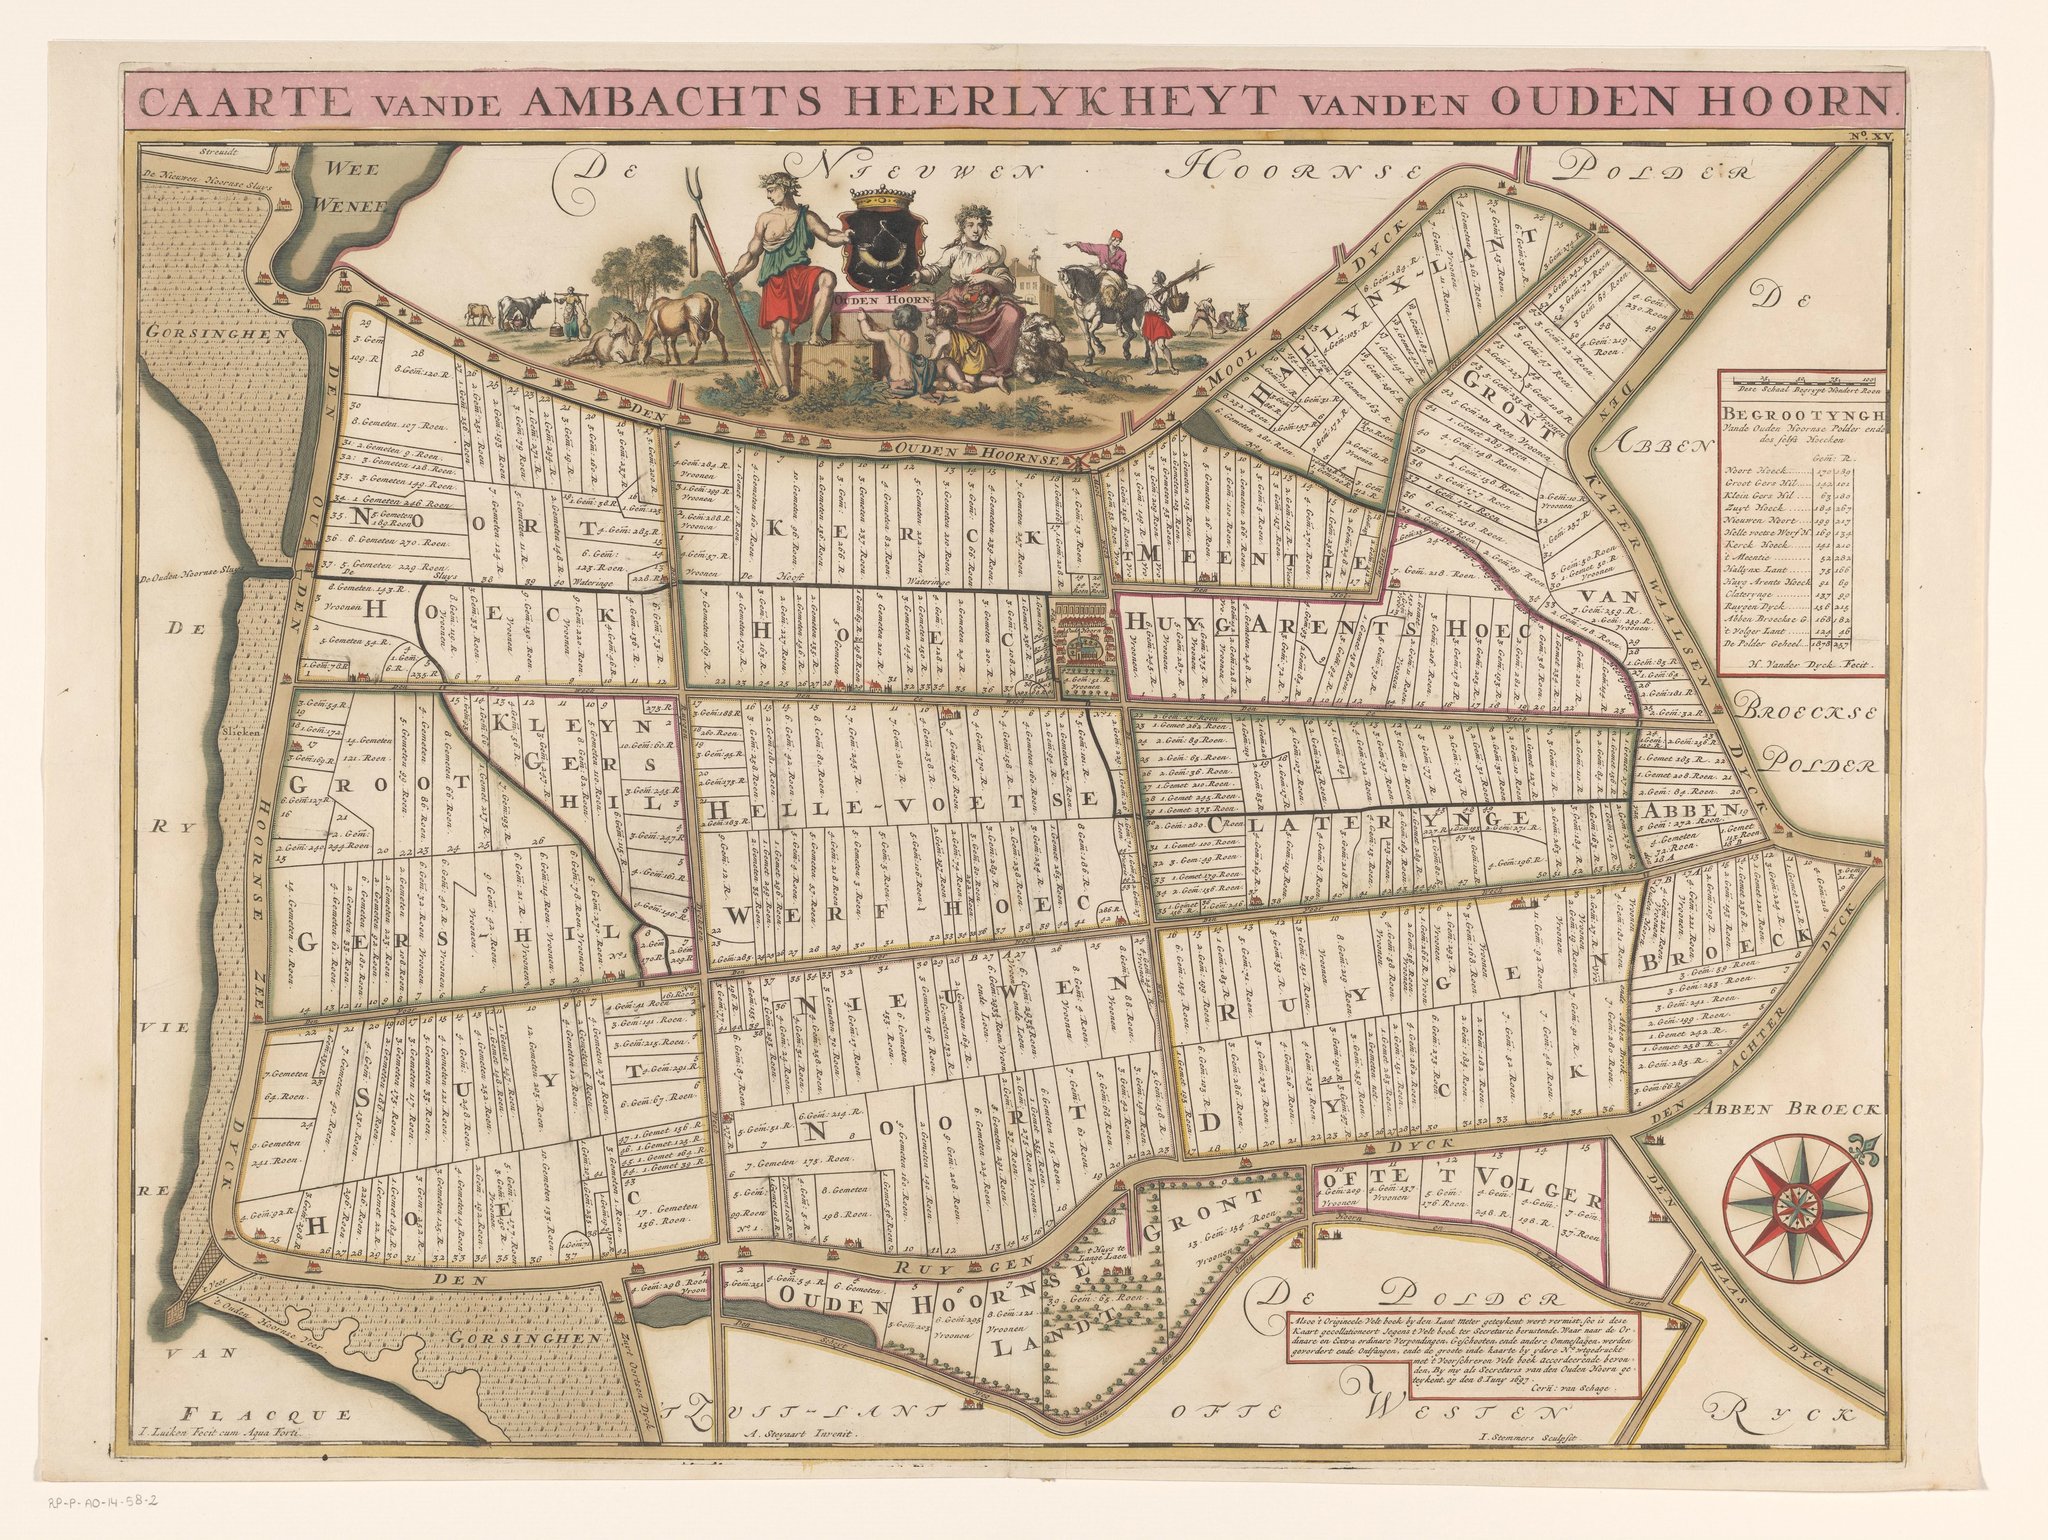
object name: map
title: Kaart van de ambachtsheerlijkheid Oudenhoorn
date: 1701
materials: paper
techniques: engraving, etching, hand coloring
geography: amsterdam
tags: coat of arms (as symbol of the state, etc.), (story of) ceres (demeter), agricultural implements: pitchfork, maps of separate countries or regions, farmers, agricultural implements: flail, carrying something with yoke, polder, reclaimed land, milkmaid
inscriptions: collector's mark: Lugt 19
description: Deze kaart is onderdeel van het zogenaamde 'Voorne Caart-boeck' / 'Caartboeck van Voorne', dat bestaat uit een titelpagina (zie RP-P-1942-347), drie algemene kaarten (van Oost-, West- en Zuid-Voorne)* en dertig detailkaarten. Het kaartboek werd vervaardigd in opdracht van de Staten van Voorne en werd in 1701 uitgegeven. Een deel van de koperplaten is bewaard gebleven en in de negentiende en twintigste eeuw gebruikt voor herdrukken. *Over de naam Voorne kan verwarring ontstaan omdat de betekenis door de eeuwen heen is veranderd. Vroeger stonden de (voormalige) eilanden Voorne, Goeree en Overflakkee – allen historisch gezien onderdeel van het Land van Voorne – bekend als respectievelijk Oost-, West- en Zuid-Voorne.